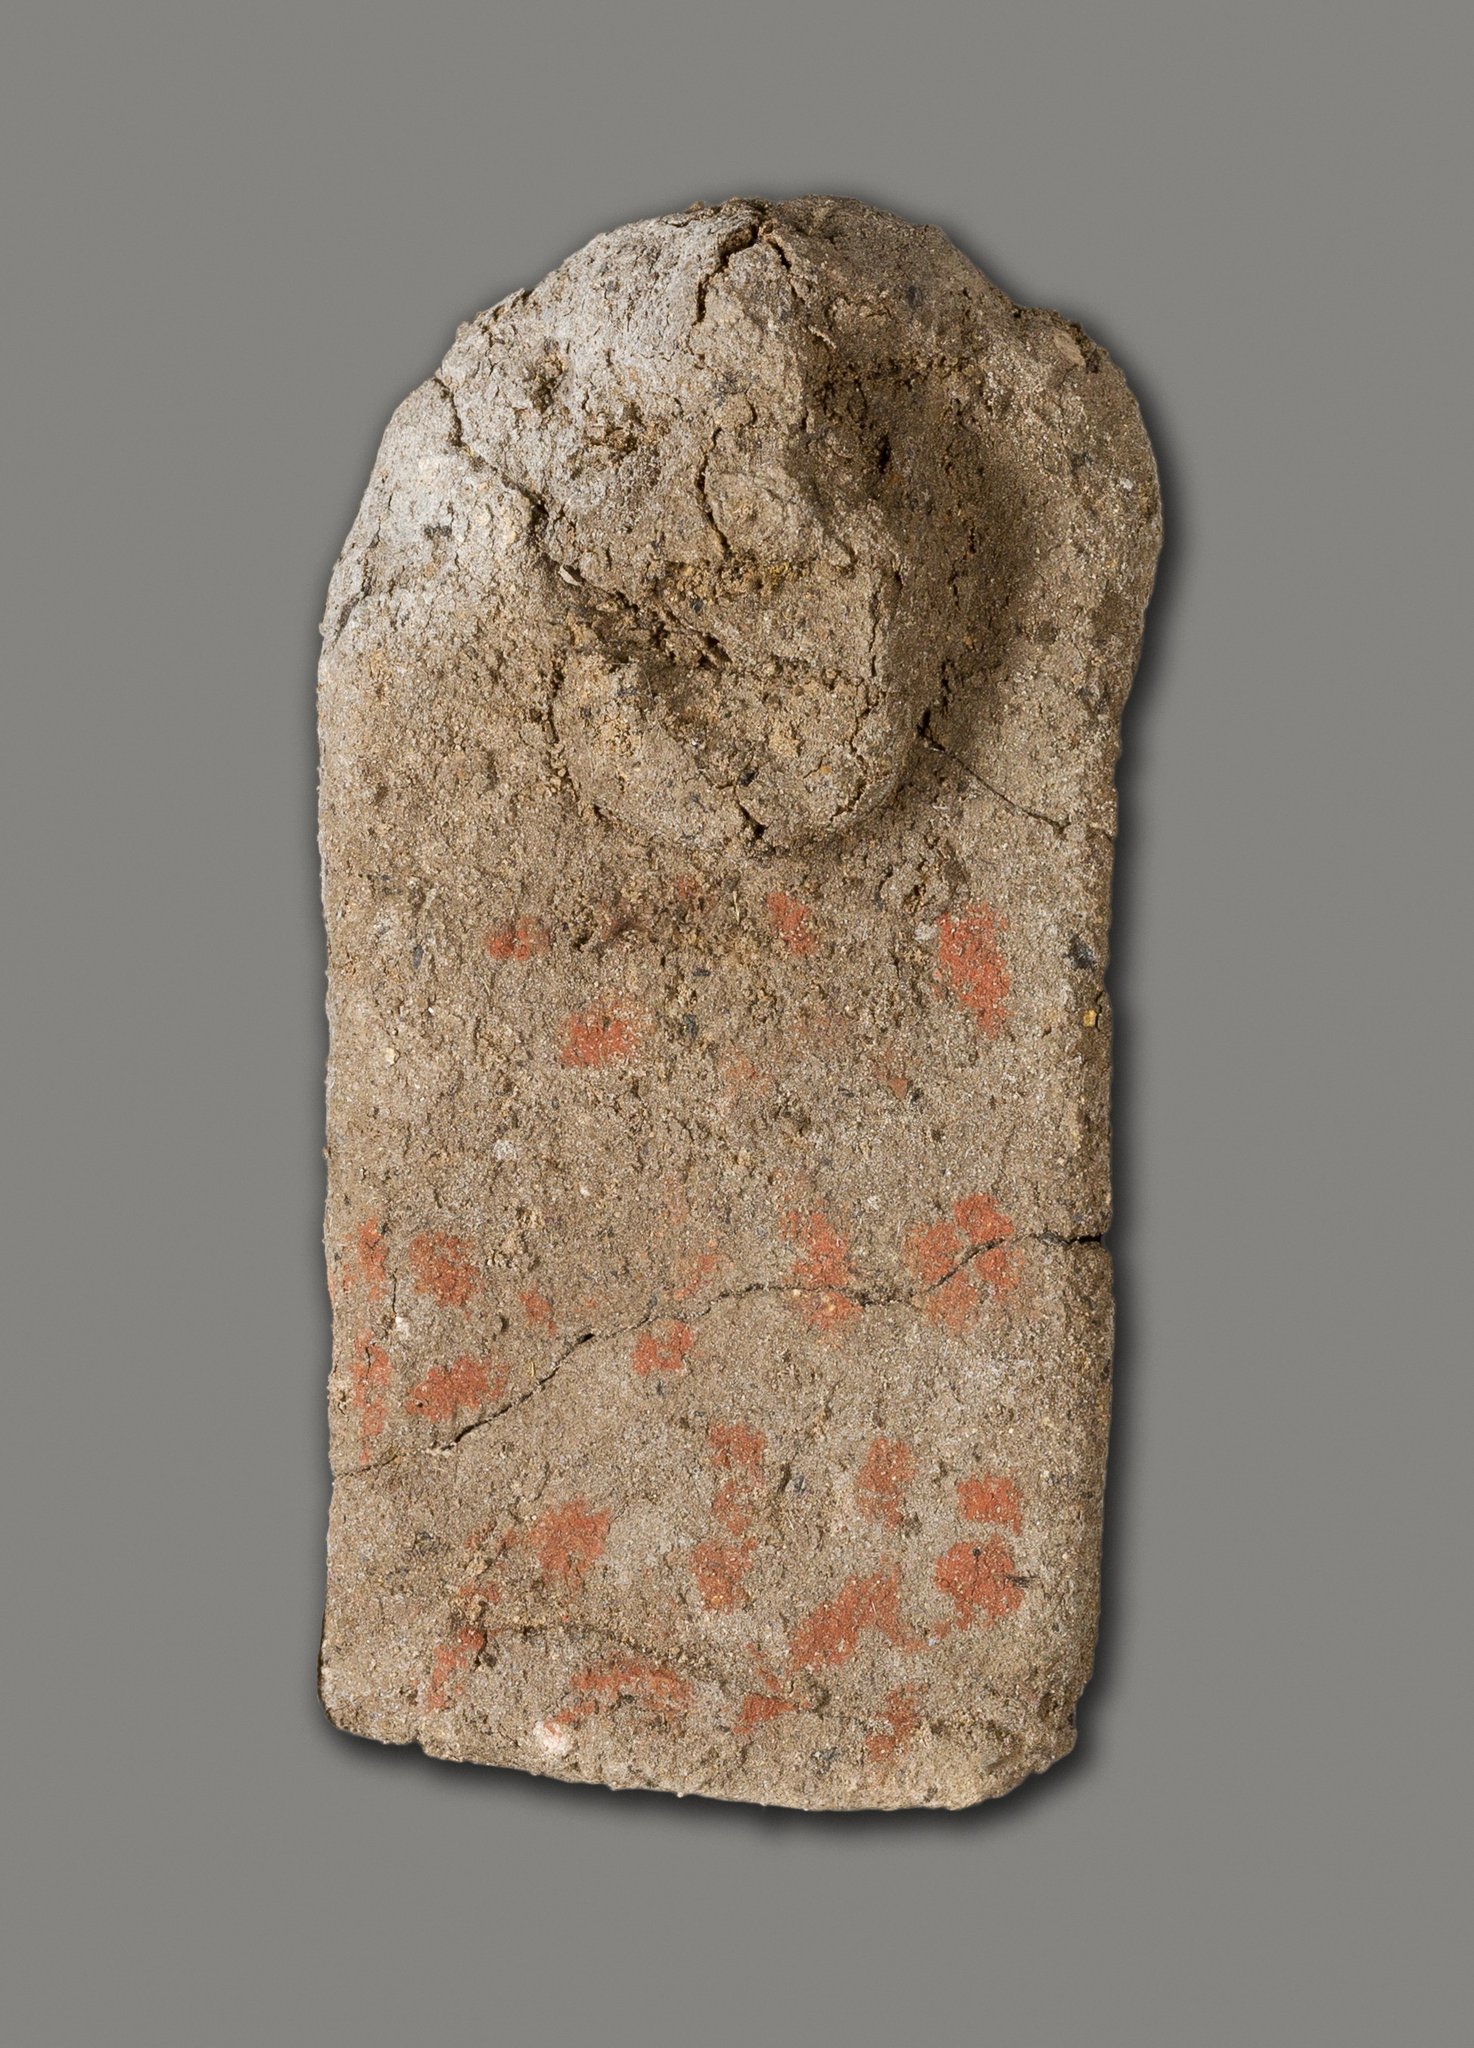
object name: figure, magical, execration, tablet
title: Magical Figure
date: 1802-1550 BCE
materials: clay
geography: egypt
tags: faces